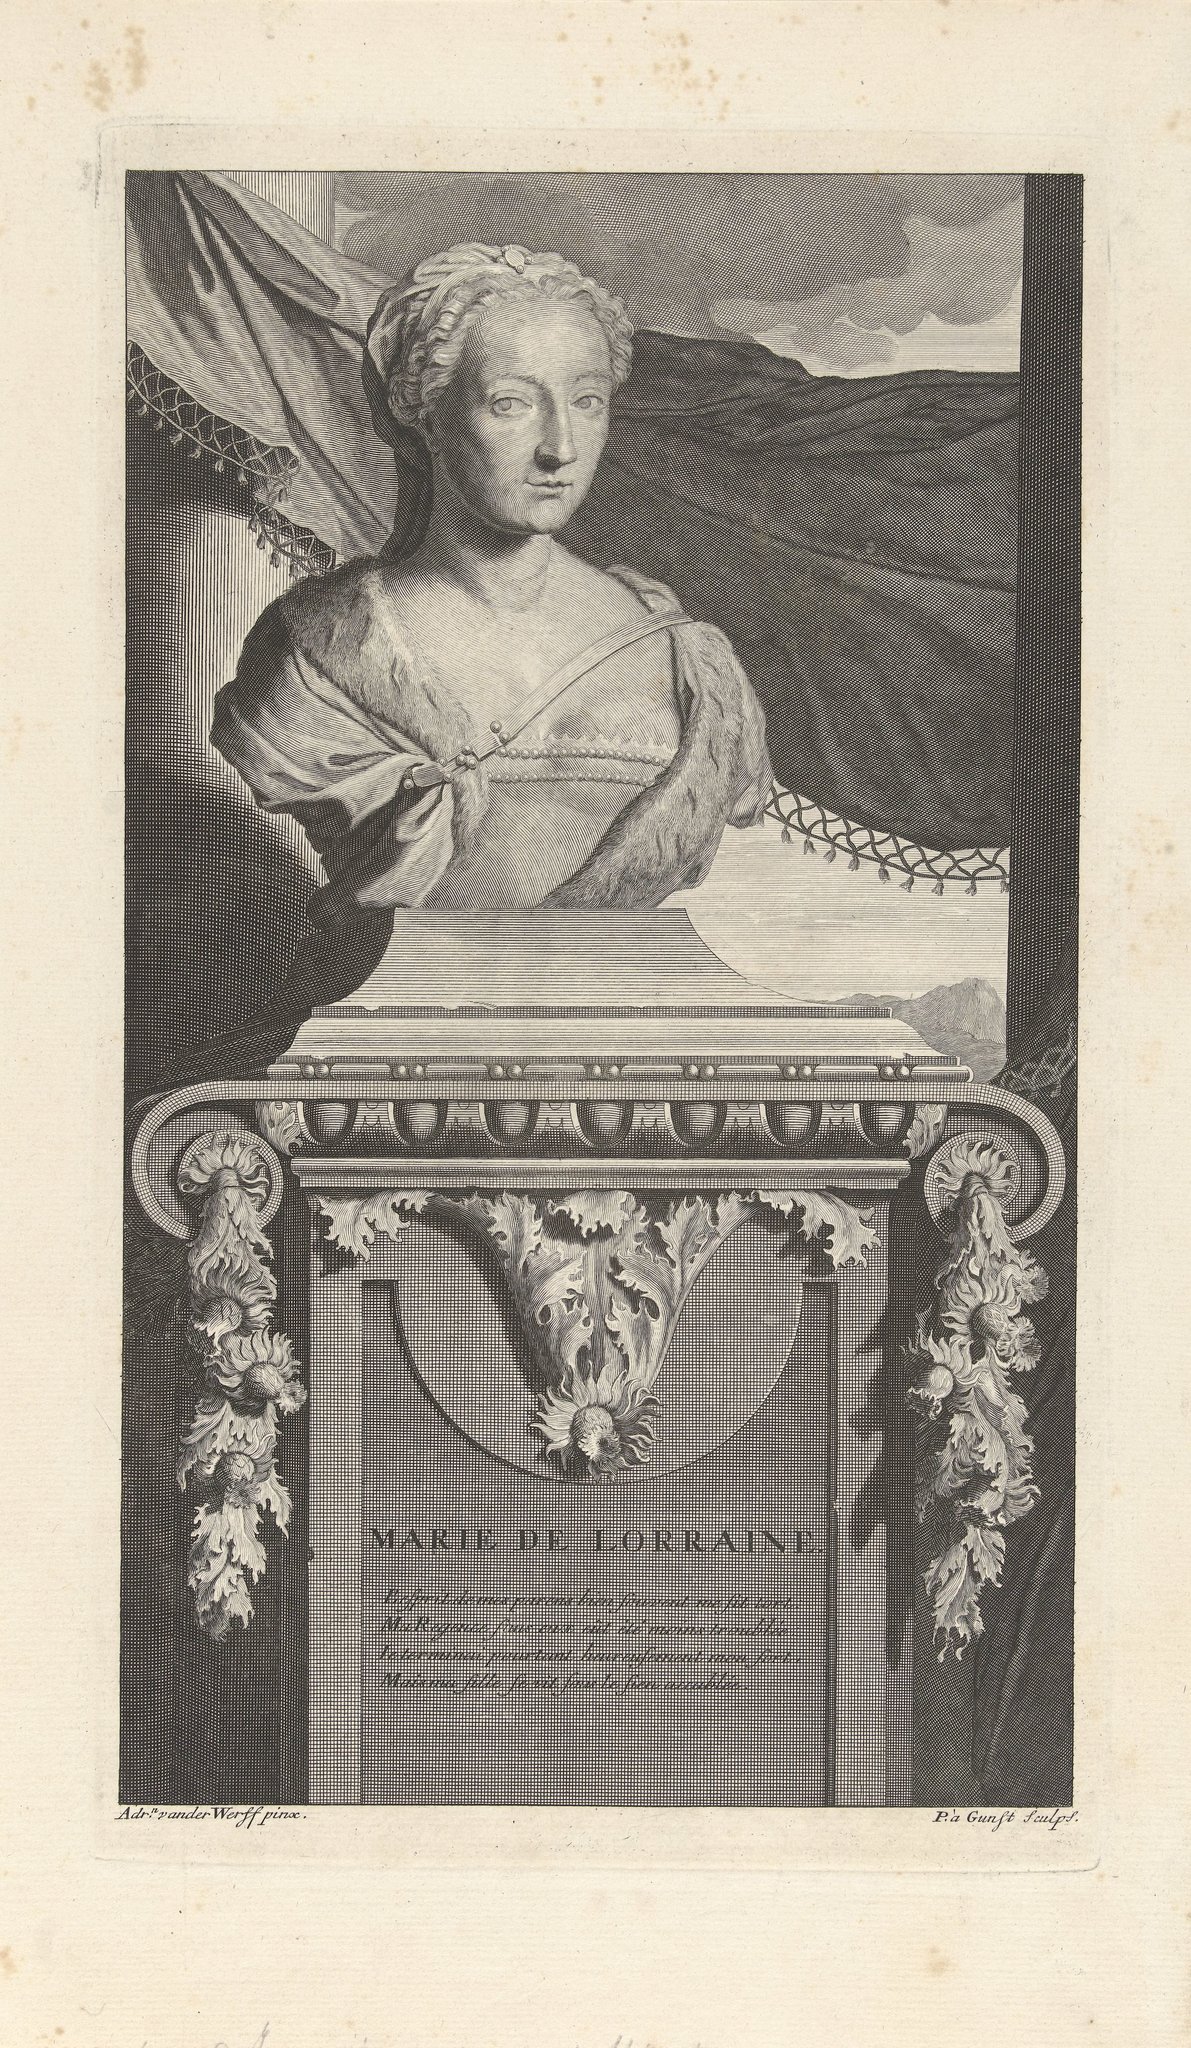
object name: print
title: Buste van Maria van Guise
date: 1669-1731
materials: paper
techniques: engraving, etching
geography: amsterdam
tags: marie de lorraine (koningin van schotland)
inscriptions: collector's mark: Lugt 2228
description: Standbeeldbuste van Marie de Lorraine en Guise, koningin van Schotland en latere regentes van Schotland. Het beeld staat op een voetstuk met een Frans gedicht over haar leven.